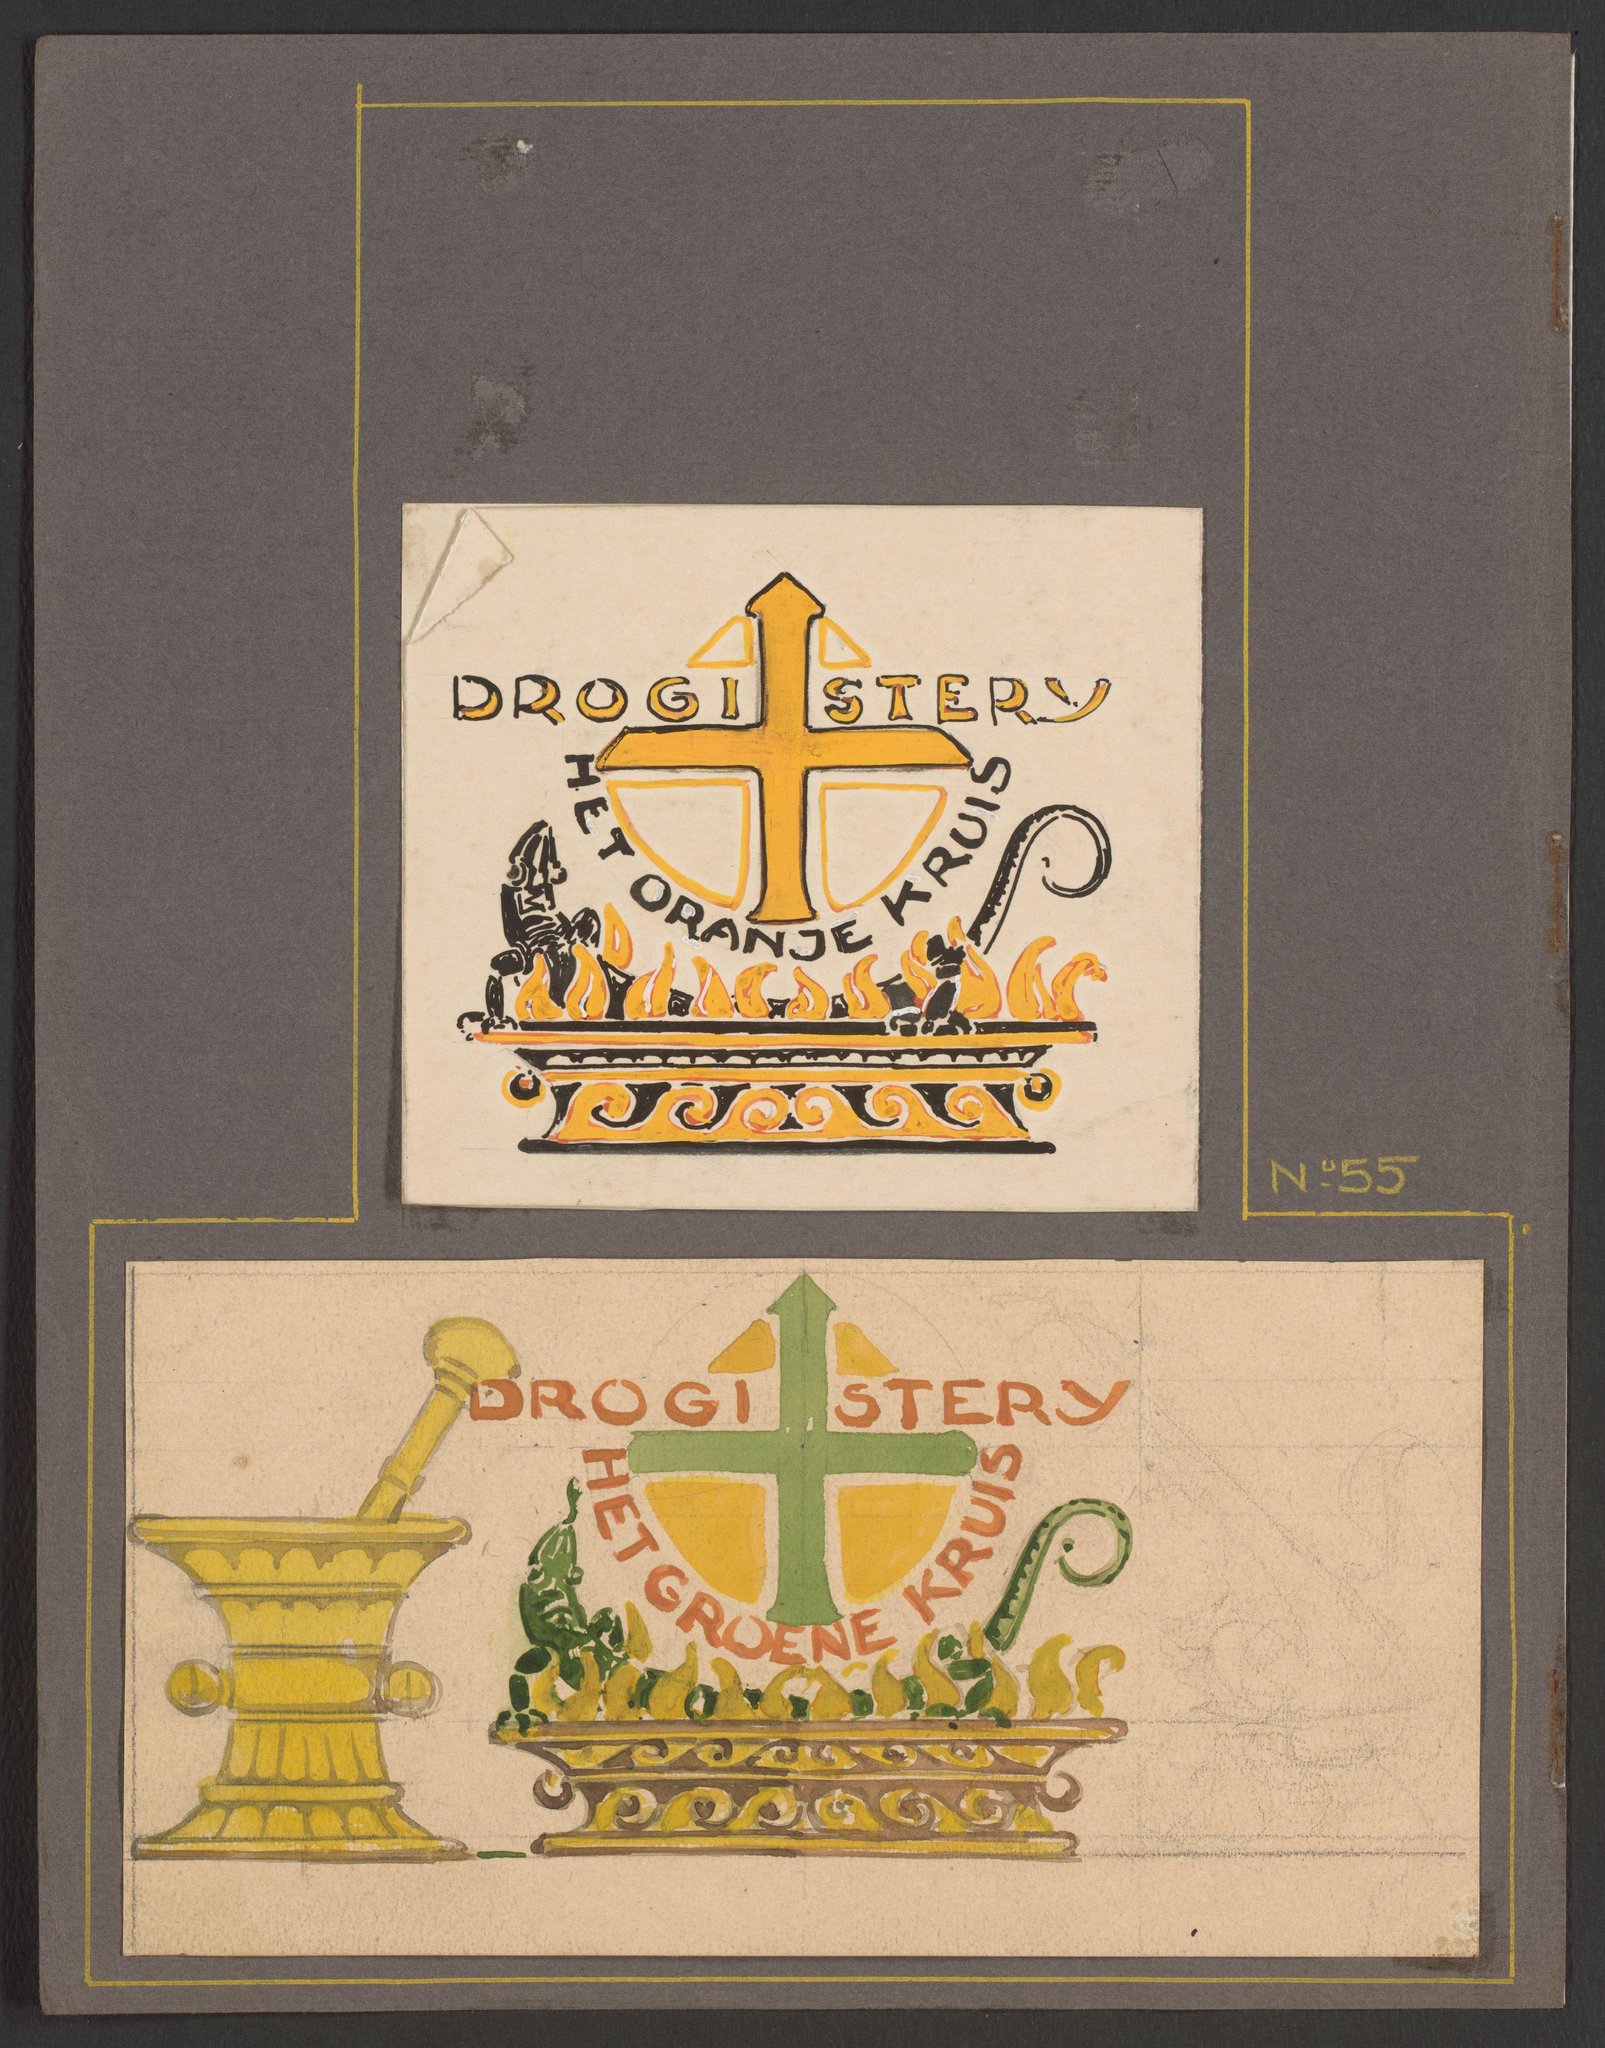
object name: drawing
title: Ontwerpen voor advertenties van drogisterij Het Oranje Kruis en drogisterij Het Groene Kruis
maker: reinier willem petrus de vries (1874-1953)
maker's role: draughtsman, print maker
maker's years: 1874-1953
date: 1884-1952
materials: paint, ink, paper, pencil, watercolor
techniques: brush, pen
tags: alchemistic symbols, container of ceramics: jar, jug, pot, vase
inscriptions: number: ‘No 55’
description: Ontwerpen met een kruis en een salamander die door een vuur loopt. Aan het onderste ontwerp is een apothekerspot toegevoegd.